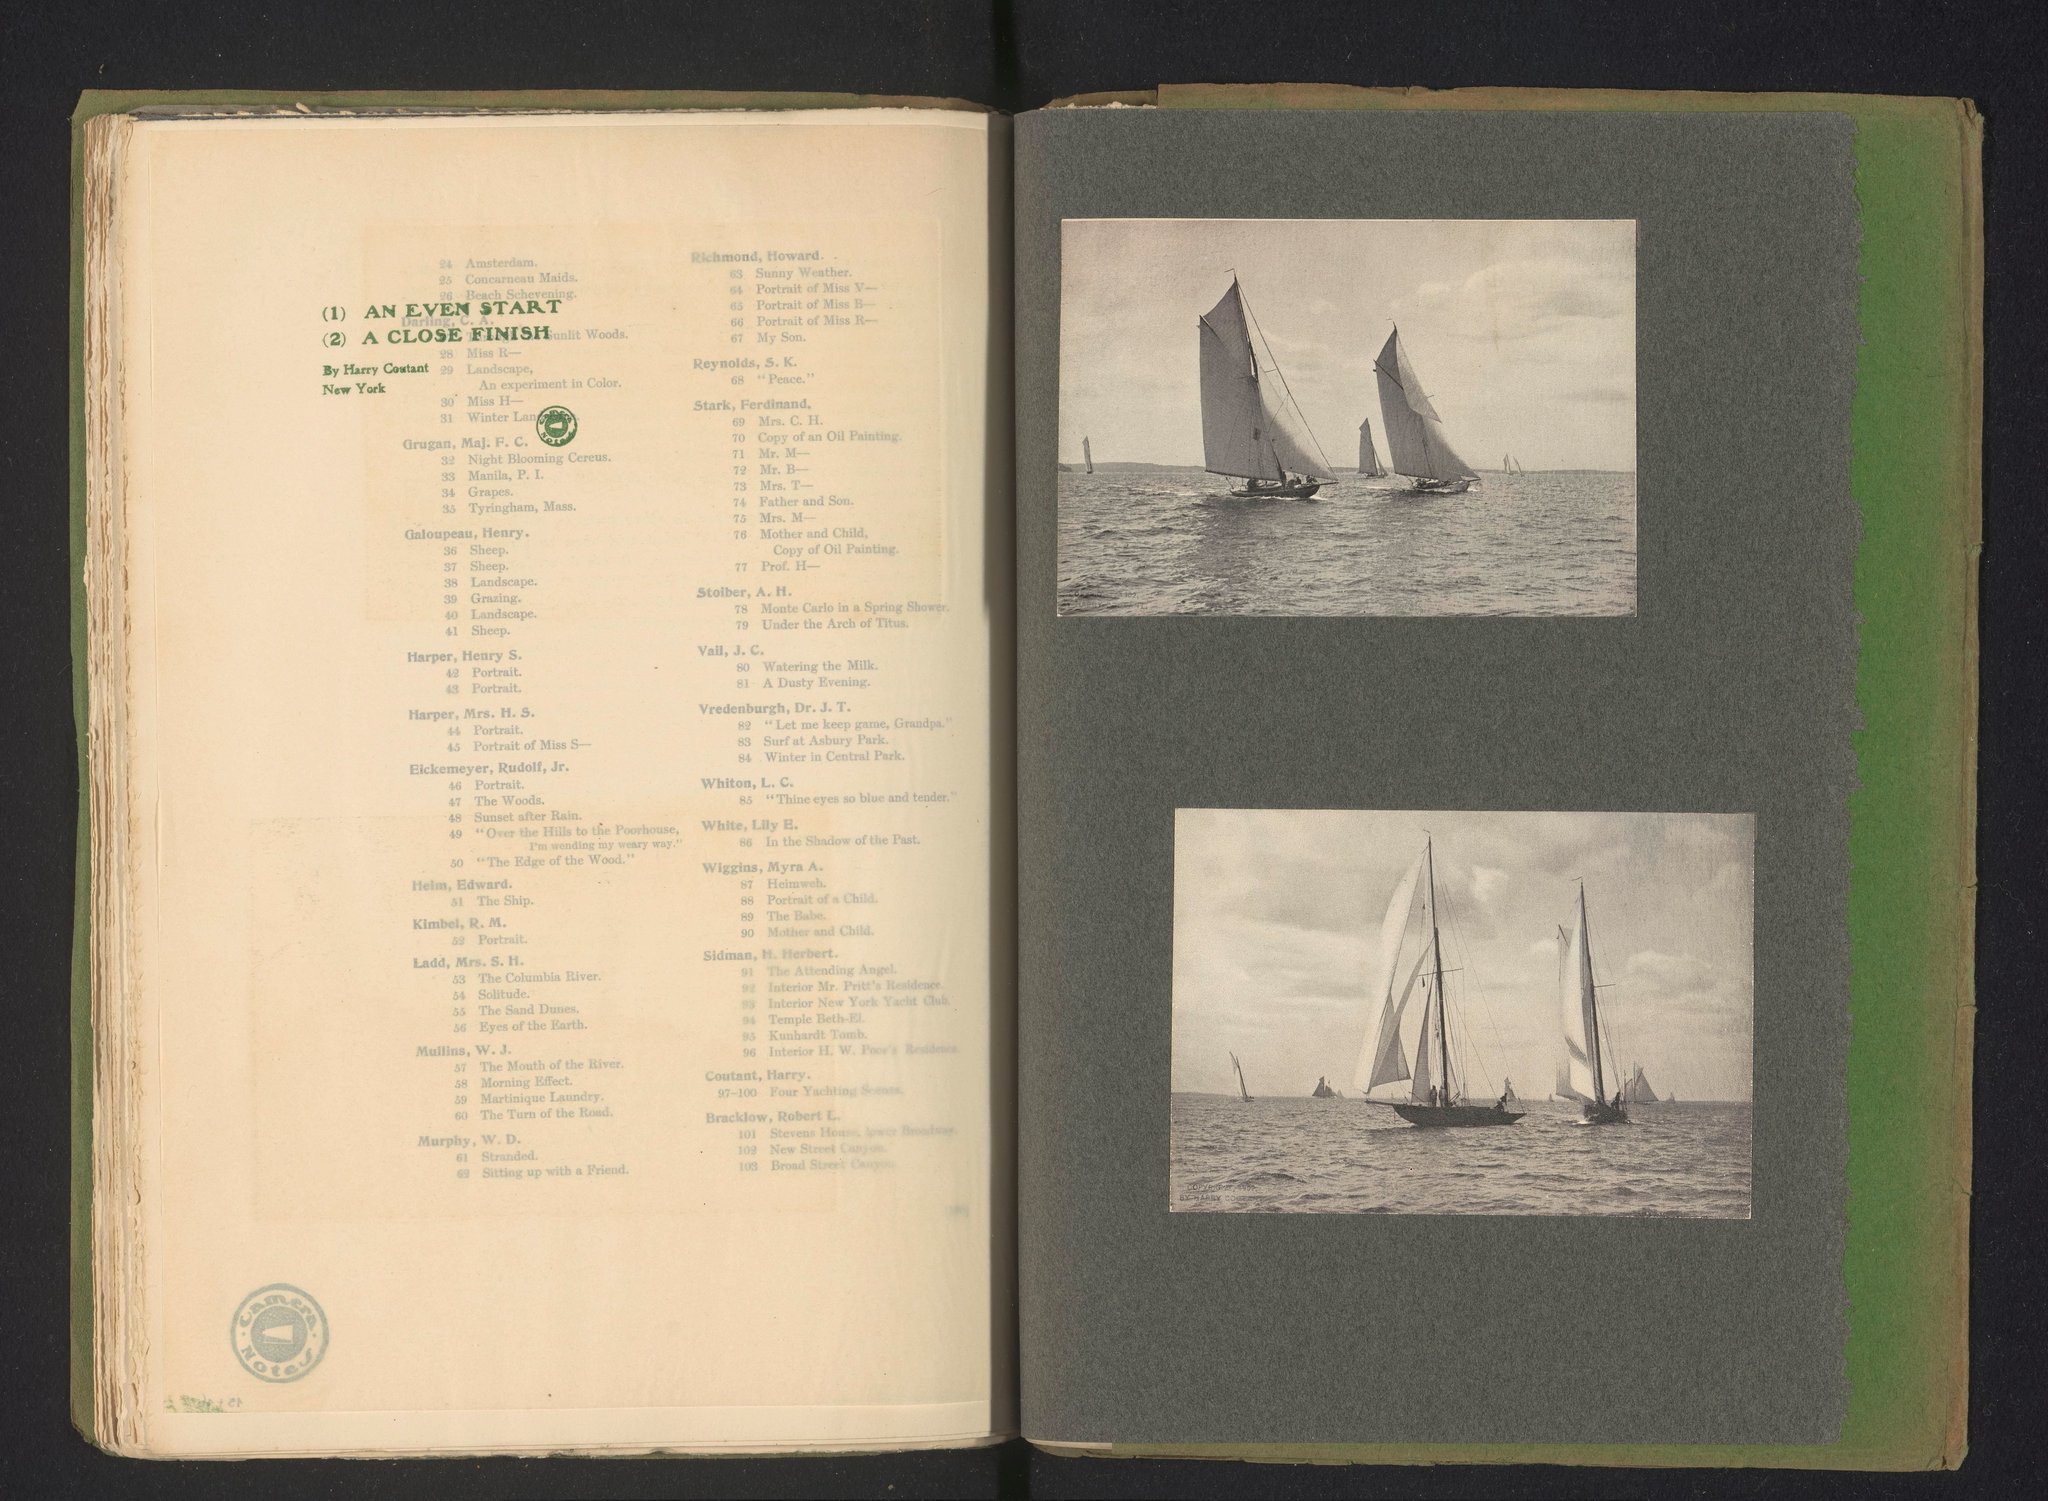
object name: page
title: An Even Start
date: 1902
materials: paper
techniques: autotype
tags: sailing-ship, sailing-boat, sea (seascape)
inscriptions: date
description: Prent tegenover pagina 130, achter semi-transparante omslag.